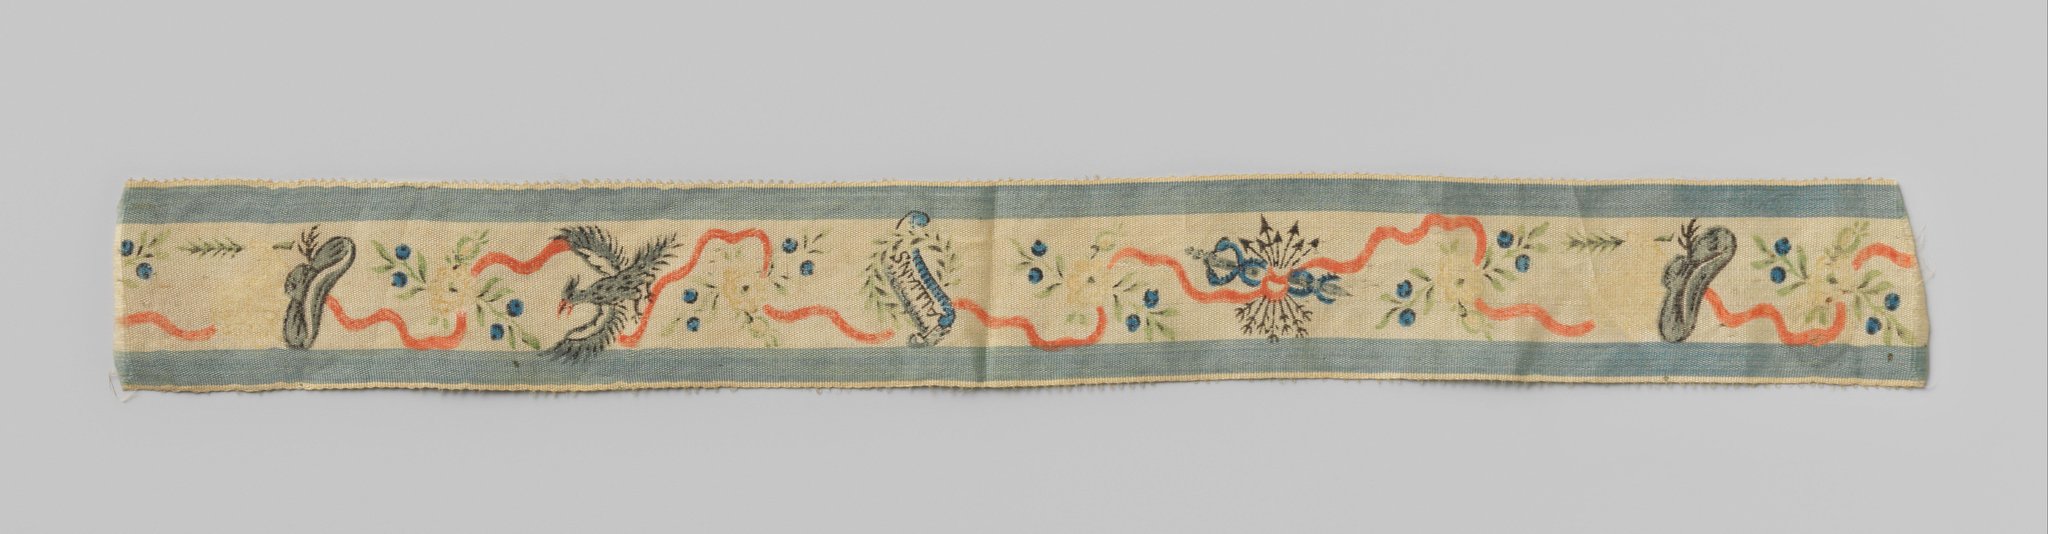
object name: ribbon material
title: Oranjelint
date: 1787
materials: silk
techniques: printing, weave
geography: netherlands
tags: the hague, william v (prince of orange)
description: Blauw lintje met witte baan waarin een rood lint de volgende symbolen met elkaar vebindt: hoed, appeltjes, adelaar, banderol met opschrift, pijlenbundel met staf. Opschrift: m.: ALLIANS.